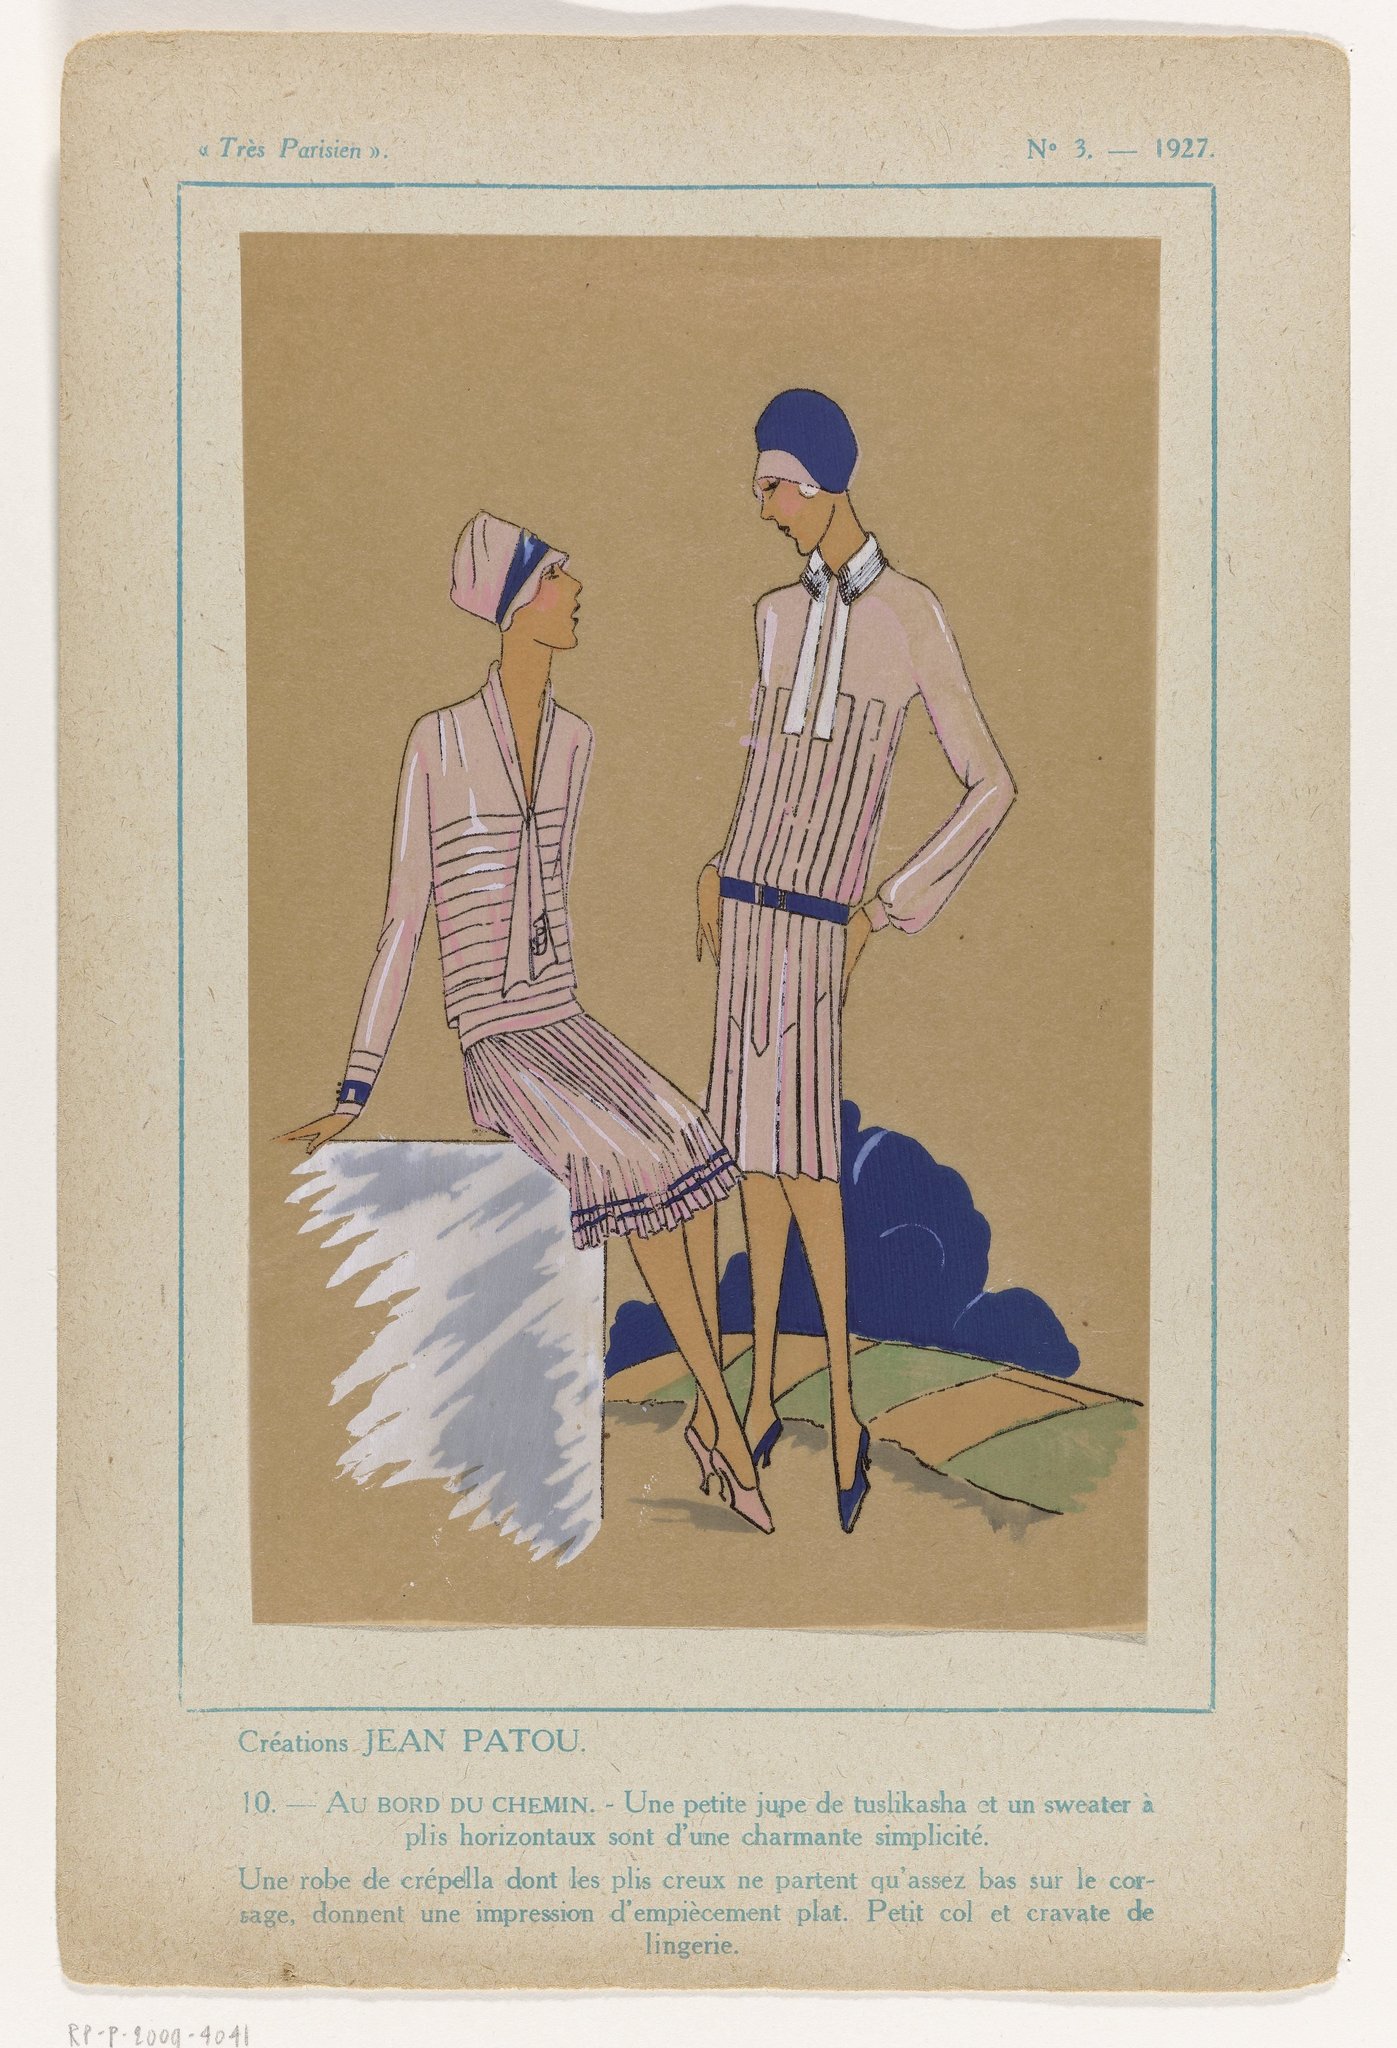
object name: fashion print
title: Très Parisien, 1927, No. 3 : -10: Créations JEAN PATOU. AU BORD DU CHEMIN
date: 1927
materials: paper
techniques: hand coloring, letterpress printing, lithography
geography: paris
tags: clothing for the upper part of the body (sweater) (+ women's clothes), neck-gear ~ clothing (cravat) (+ women's clothes), neck-gear: collar (+ women's clothes), fashion plates, skirt (+ women's clothes), dress, gown (+ women's clothes)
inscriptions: title: ‘"Très Parisien" / No 3. - 1927.’, caption: ‘Créations JEAN PATOU. / 10. - AU BORD DU CHEMIN. - Une petite jupe de turlikasha et un sweater à plis horizontaux sont d'une charmante simplicité. Une robe de crépella dont les plis creux ne partent qu'assez bas sur le corsage, donnent une impression d'empiècement plat. Petit col et cravate de lingerie.’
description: Ontwerpen van Jean Patou. Rok van tuslikasha en een sweater met horizontale plooien. Jurk van crépella. Kleine kraag en cravate 'de lingerie'. Prent uit het modetijdschrift Très Parisien (1920-1936).